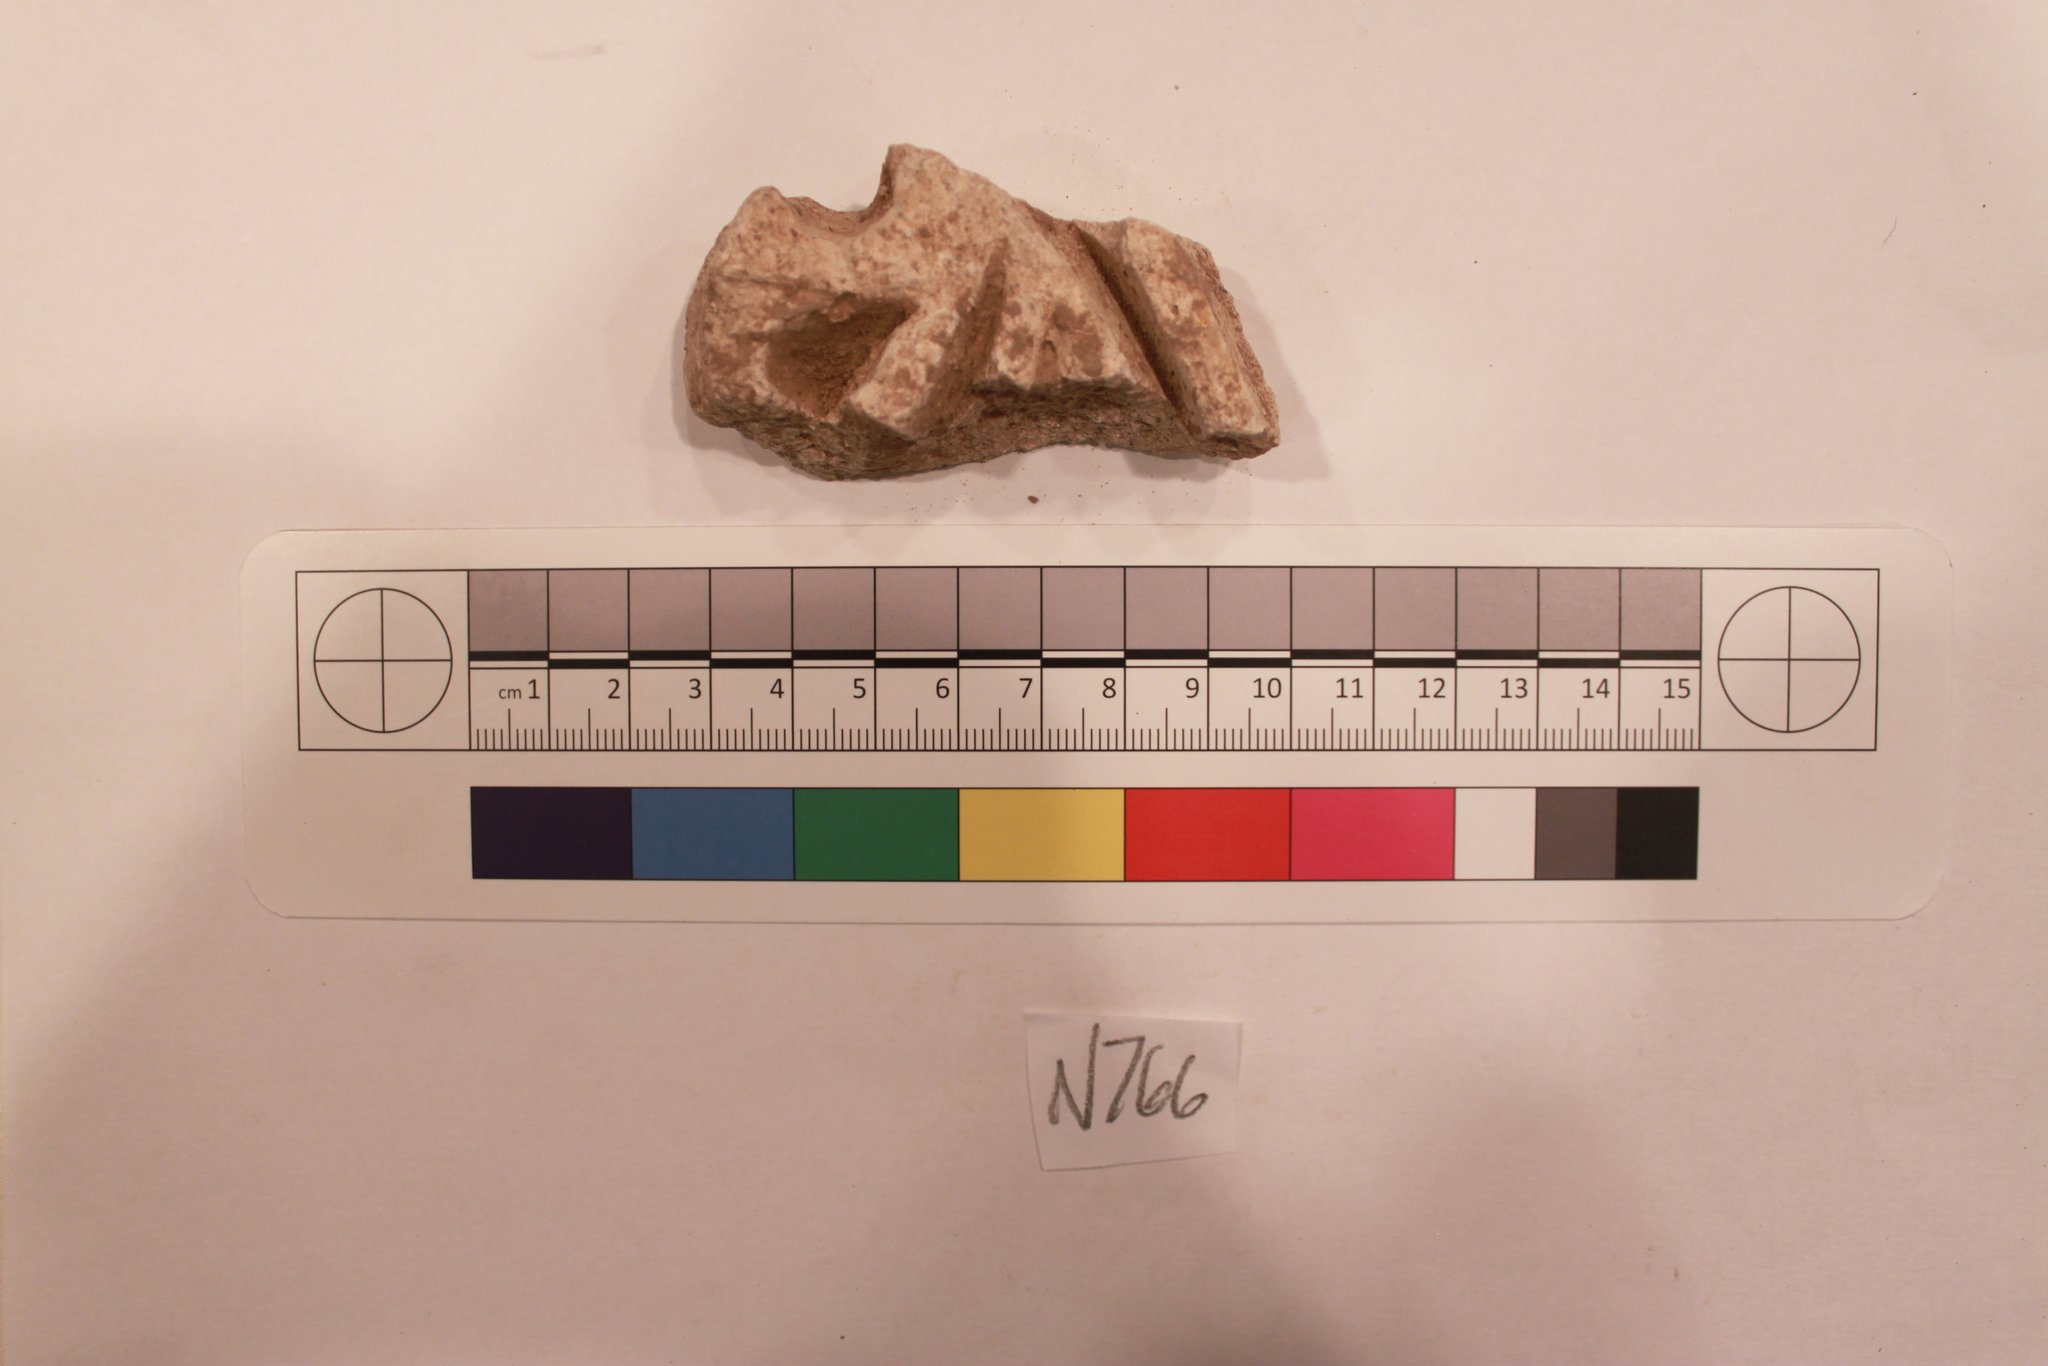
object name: fragment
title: Stucco Fragment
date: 701-1200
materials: plaster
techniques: carving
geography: iran